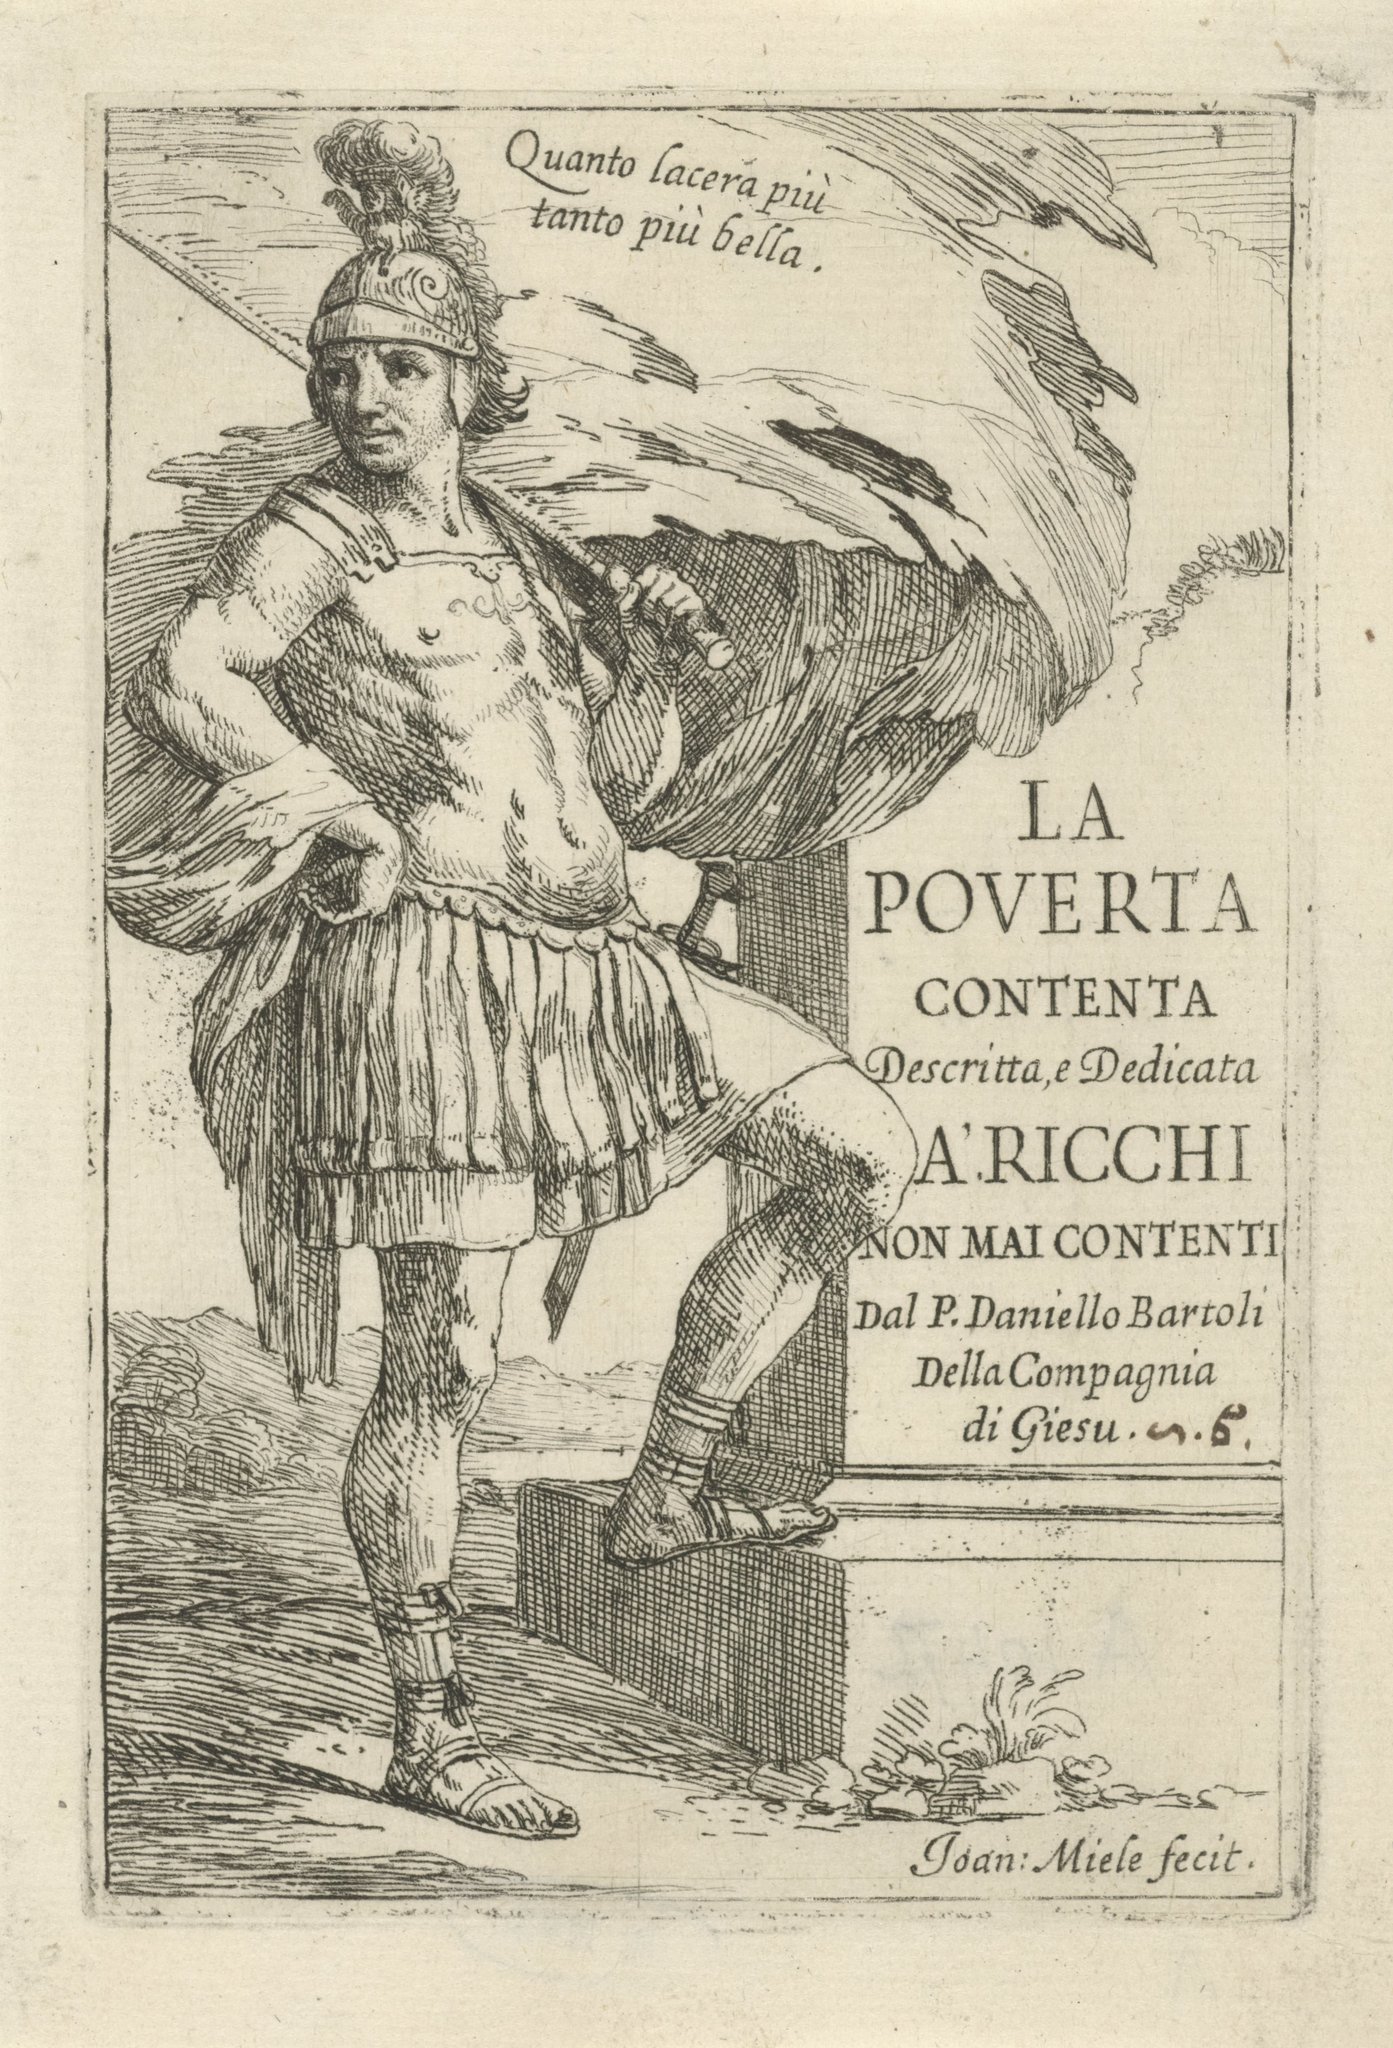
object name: titelblad, titelpagina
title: Titelpagina voor: D. Bartoli, La povertà contenta, 1649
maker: jan miel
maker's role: draughtsman, painter, print maker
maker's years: 1599-1663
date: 1649-1664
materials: paper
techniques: etching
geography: italy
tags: private soldier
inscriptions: collector's mark: Lugt 2228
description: Titelpagina voor een van de edities van: Bartoli, Daniello. La poverta contenta. s.l., 1649.